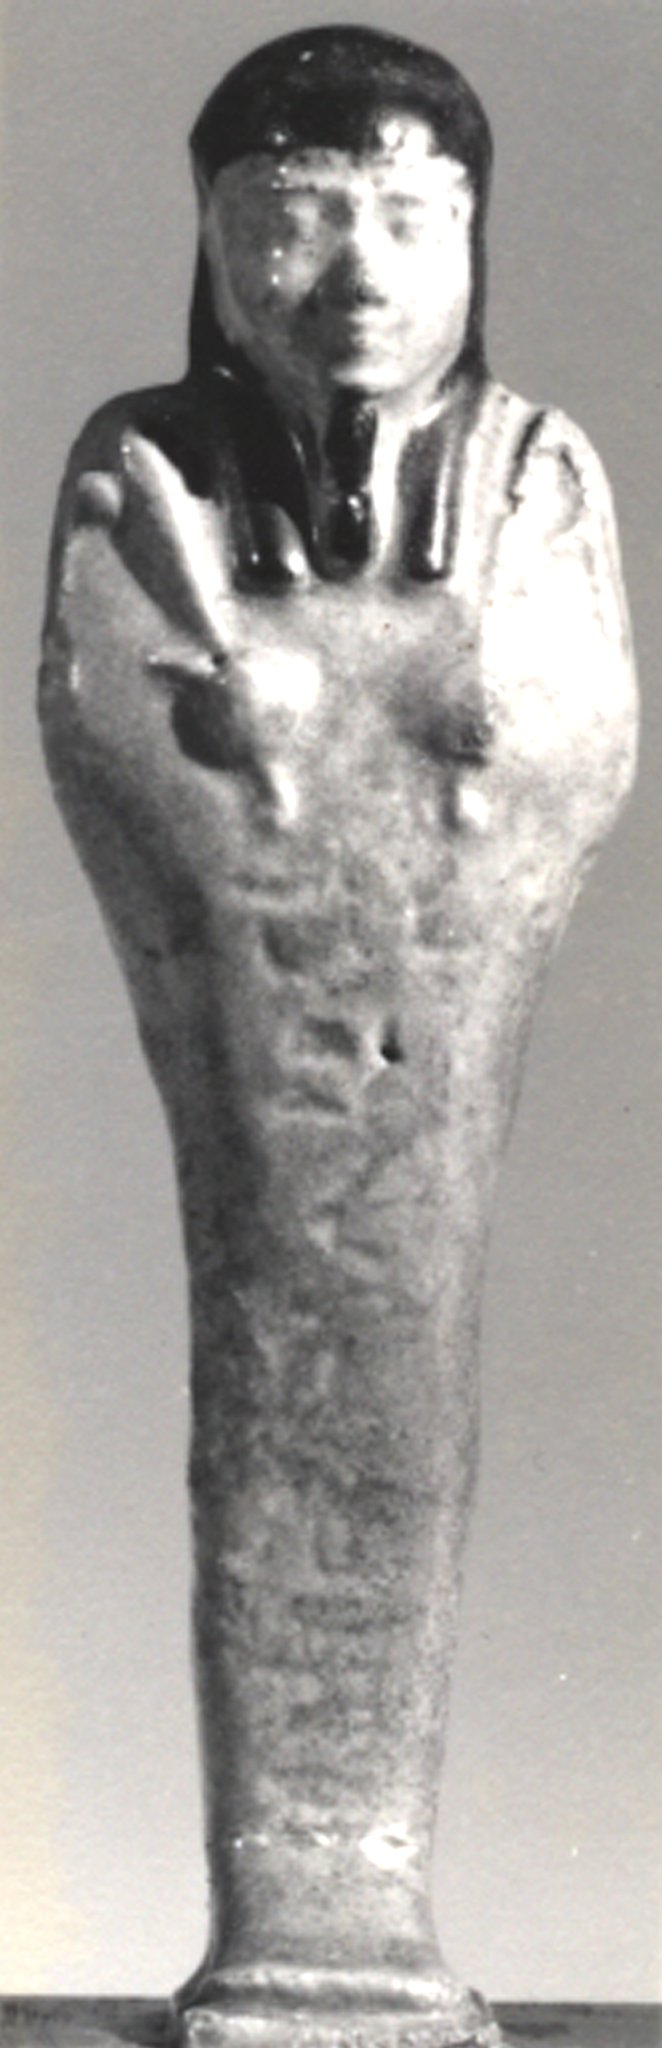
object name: shabti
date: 380-343 BCE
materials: faience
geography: egypt